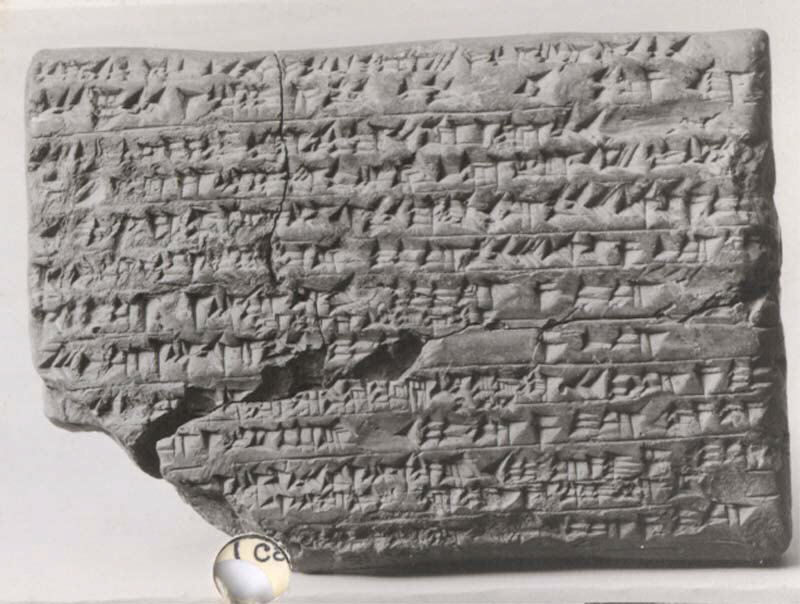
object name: cuneiform tablet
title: Cuneiform tablet: account of dates as imittu-rent, Ebabbar archive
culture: babylonian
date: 617 BCE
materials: clay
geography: mesopotamia